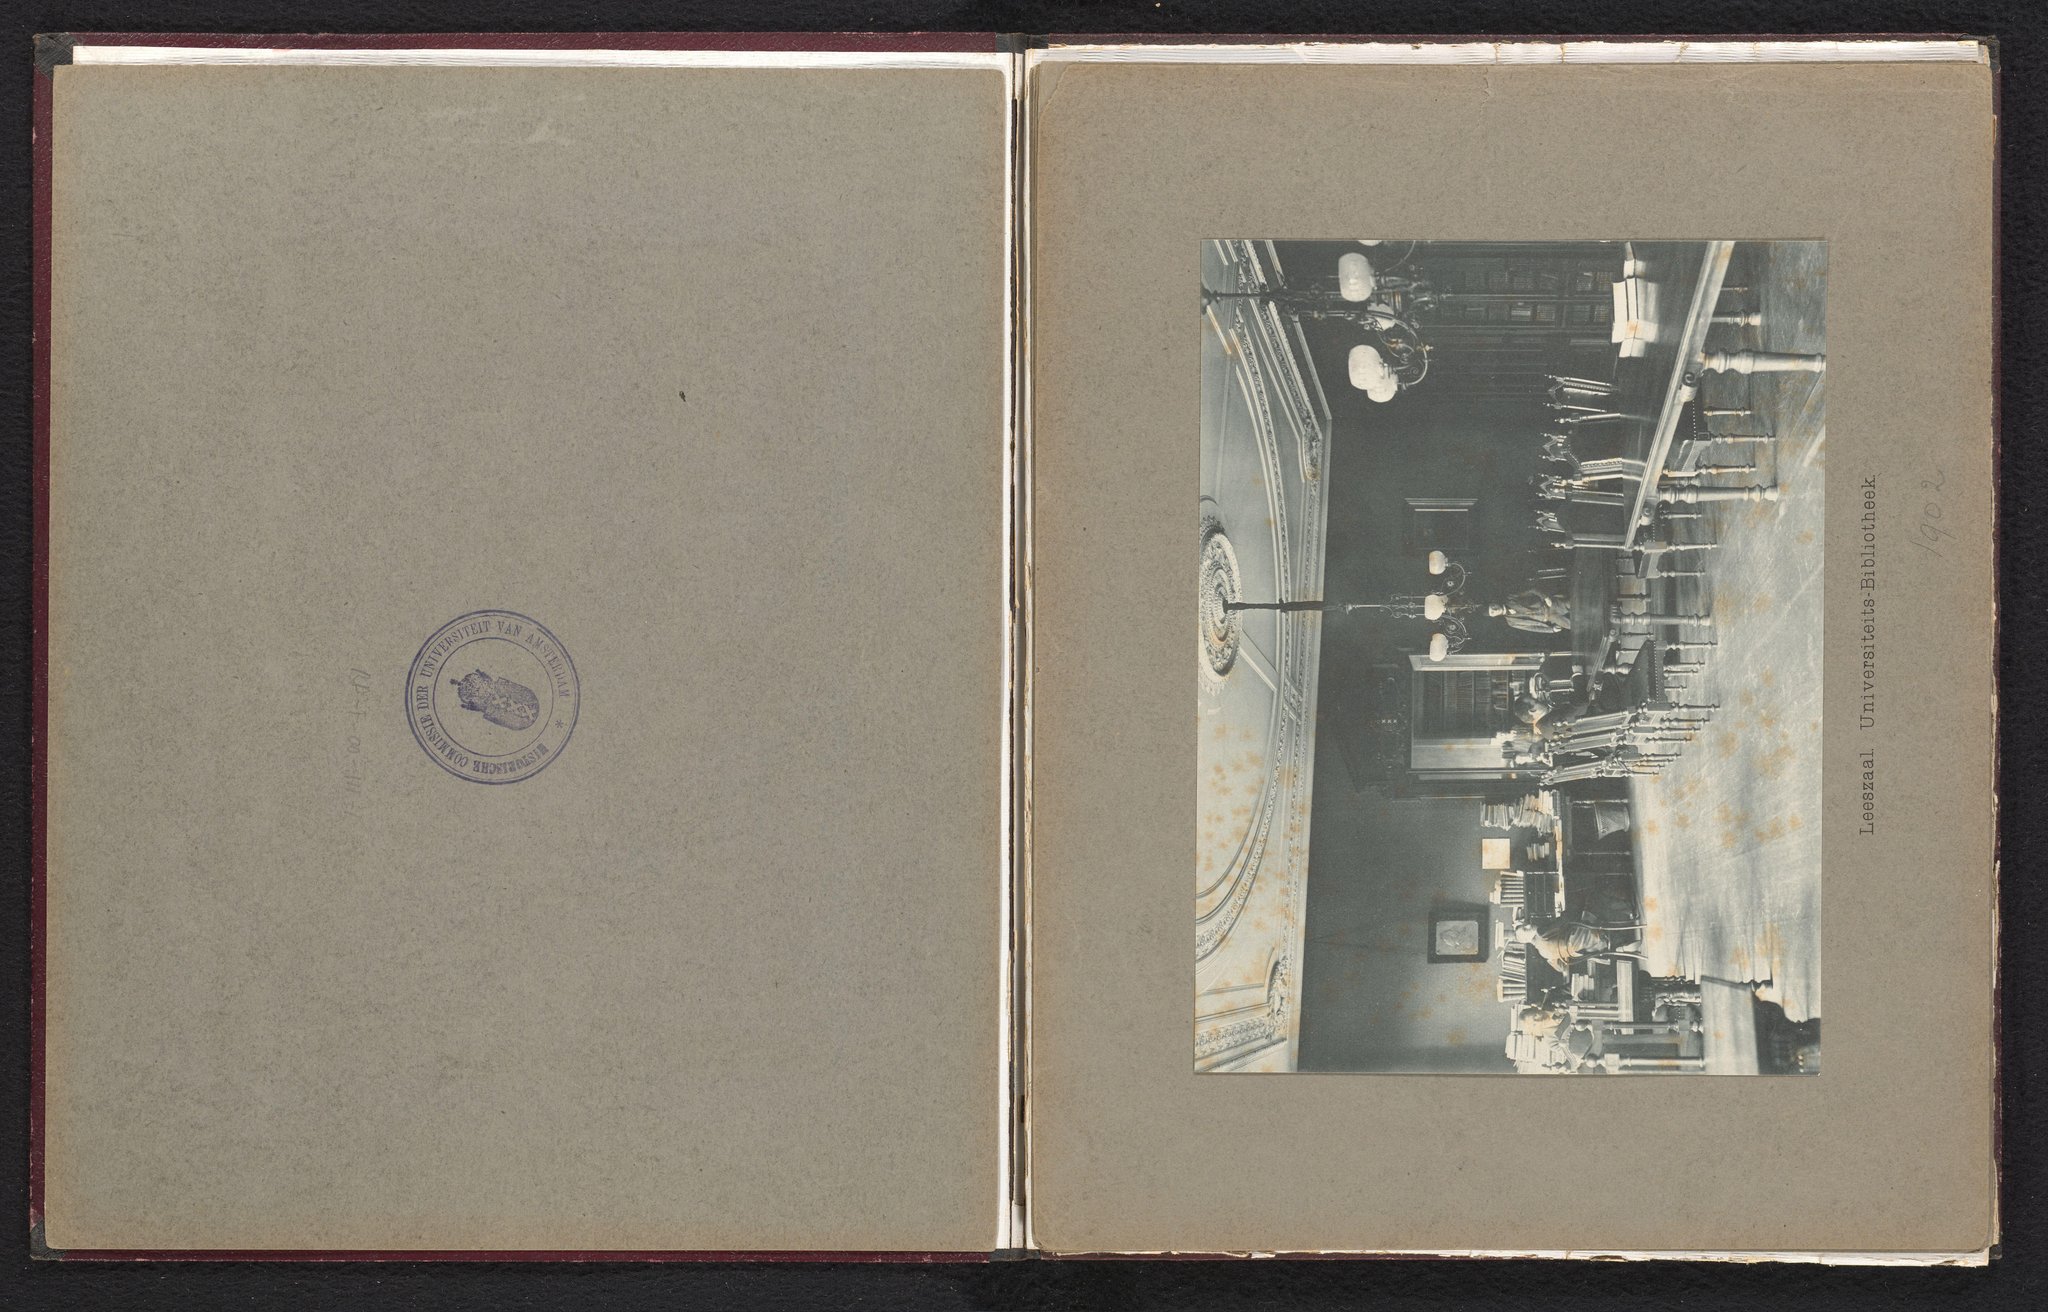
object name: photomechanical print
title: Leeszaal van de Universiteitsbibliotheek te Amsterdam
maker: Anonymous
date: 1902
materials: cardboard, paper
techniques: photograph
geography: amsterdam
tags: study; 'studiolo'; library, university building, college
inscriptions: inscription: ‘1902’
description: Deze prent maakt deel uit van een omslag met vijftien lichtdrukken op twaalf kartonnen bladen.